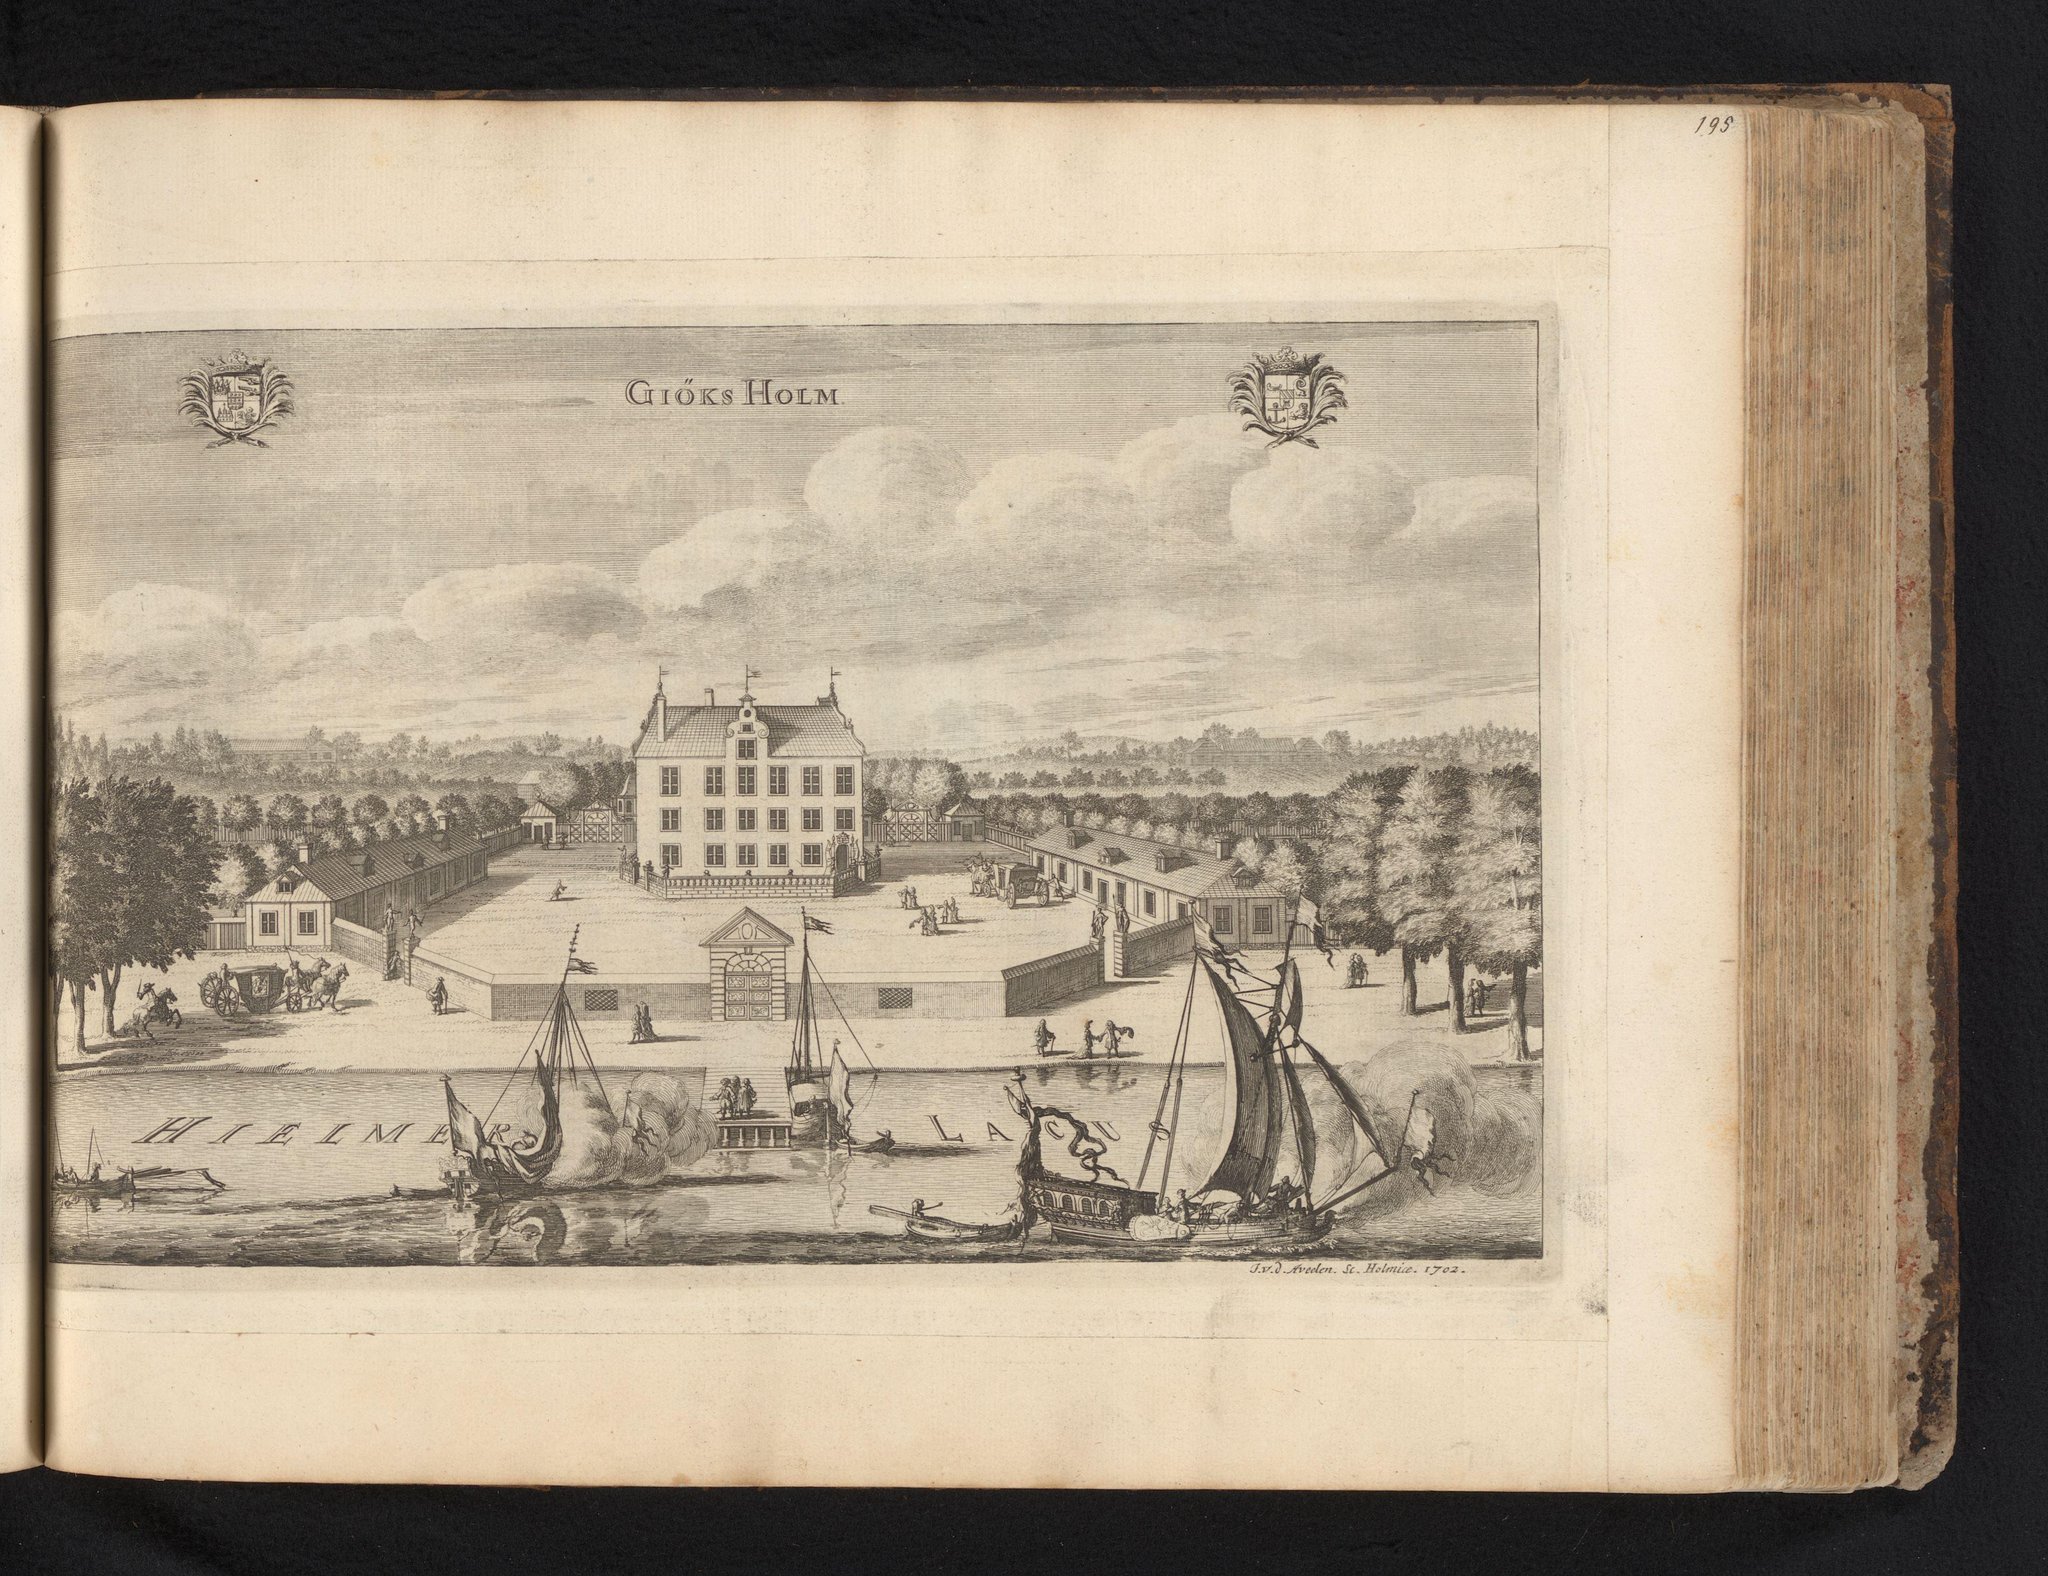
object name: album leaf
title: Suecia Antiqua et Hodierna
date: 1702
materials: paper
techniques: etching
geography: stockholm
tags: housing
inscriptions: date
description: Kungliga Biblioteket, 'Suecia': http://www.kb.se/samlingarna/Kartor-bilder/Suecia-antiqua/ (geraadpleegd november 2016).